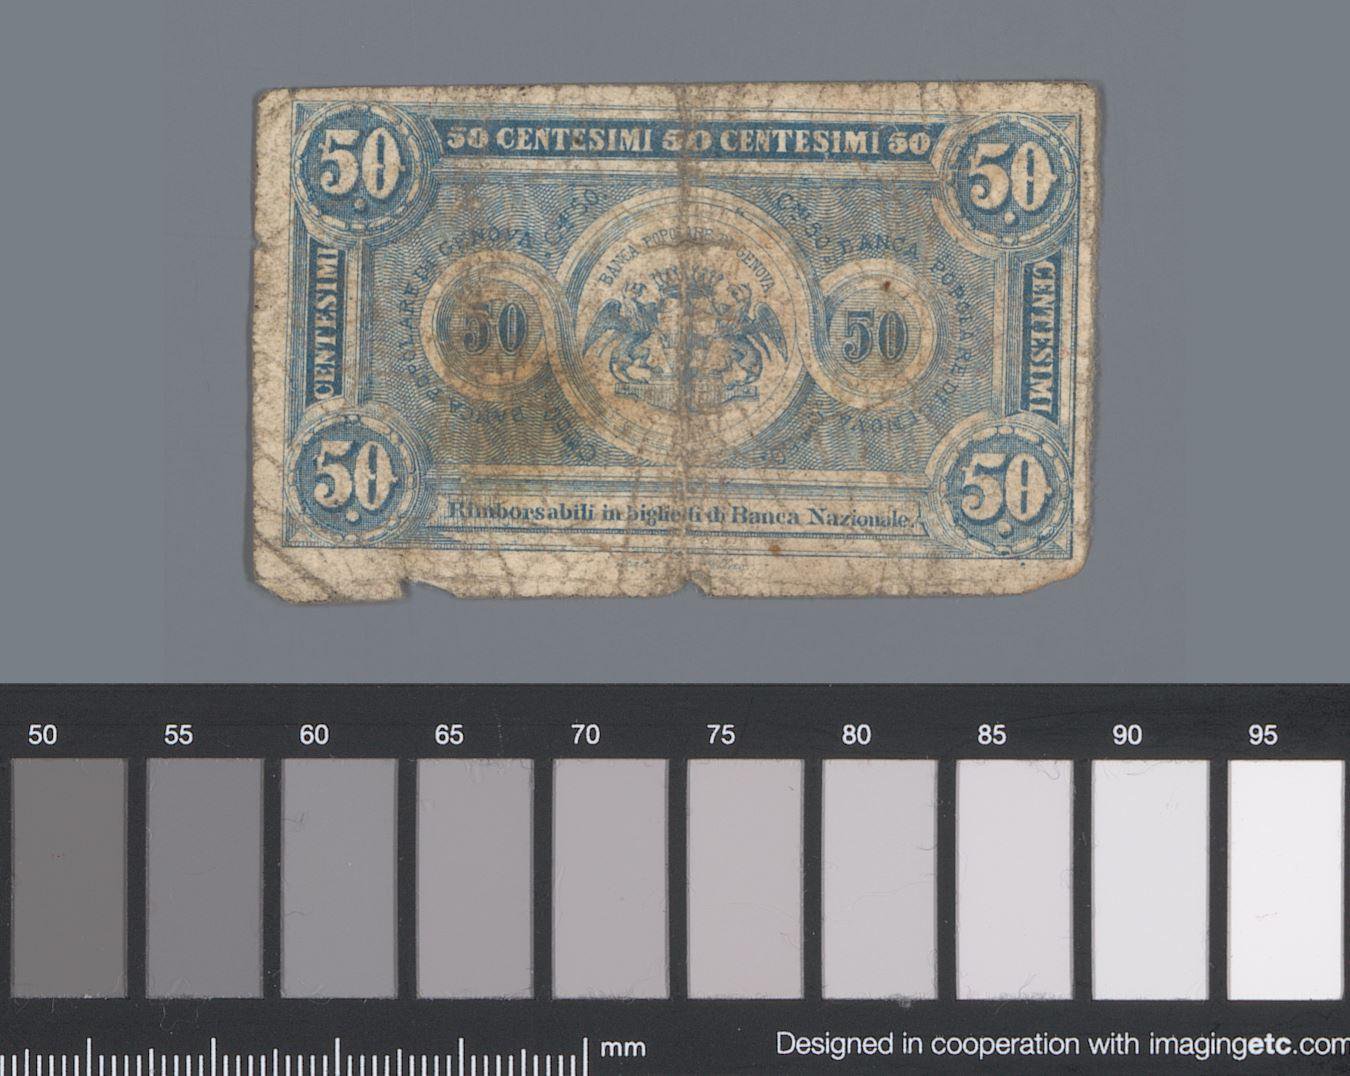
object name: waardepapier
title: Vijftig centisimi, serie G, no. 23607 uitgegeven door de Banca popolare di Genova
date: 1868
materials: paper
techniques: printing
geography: genoa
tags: genua